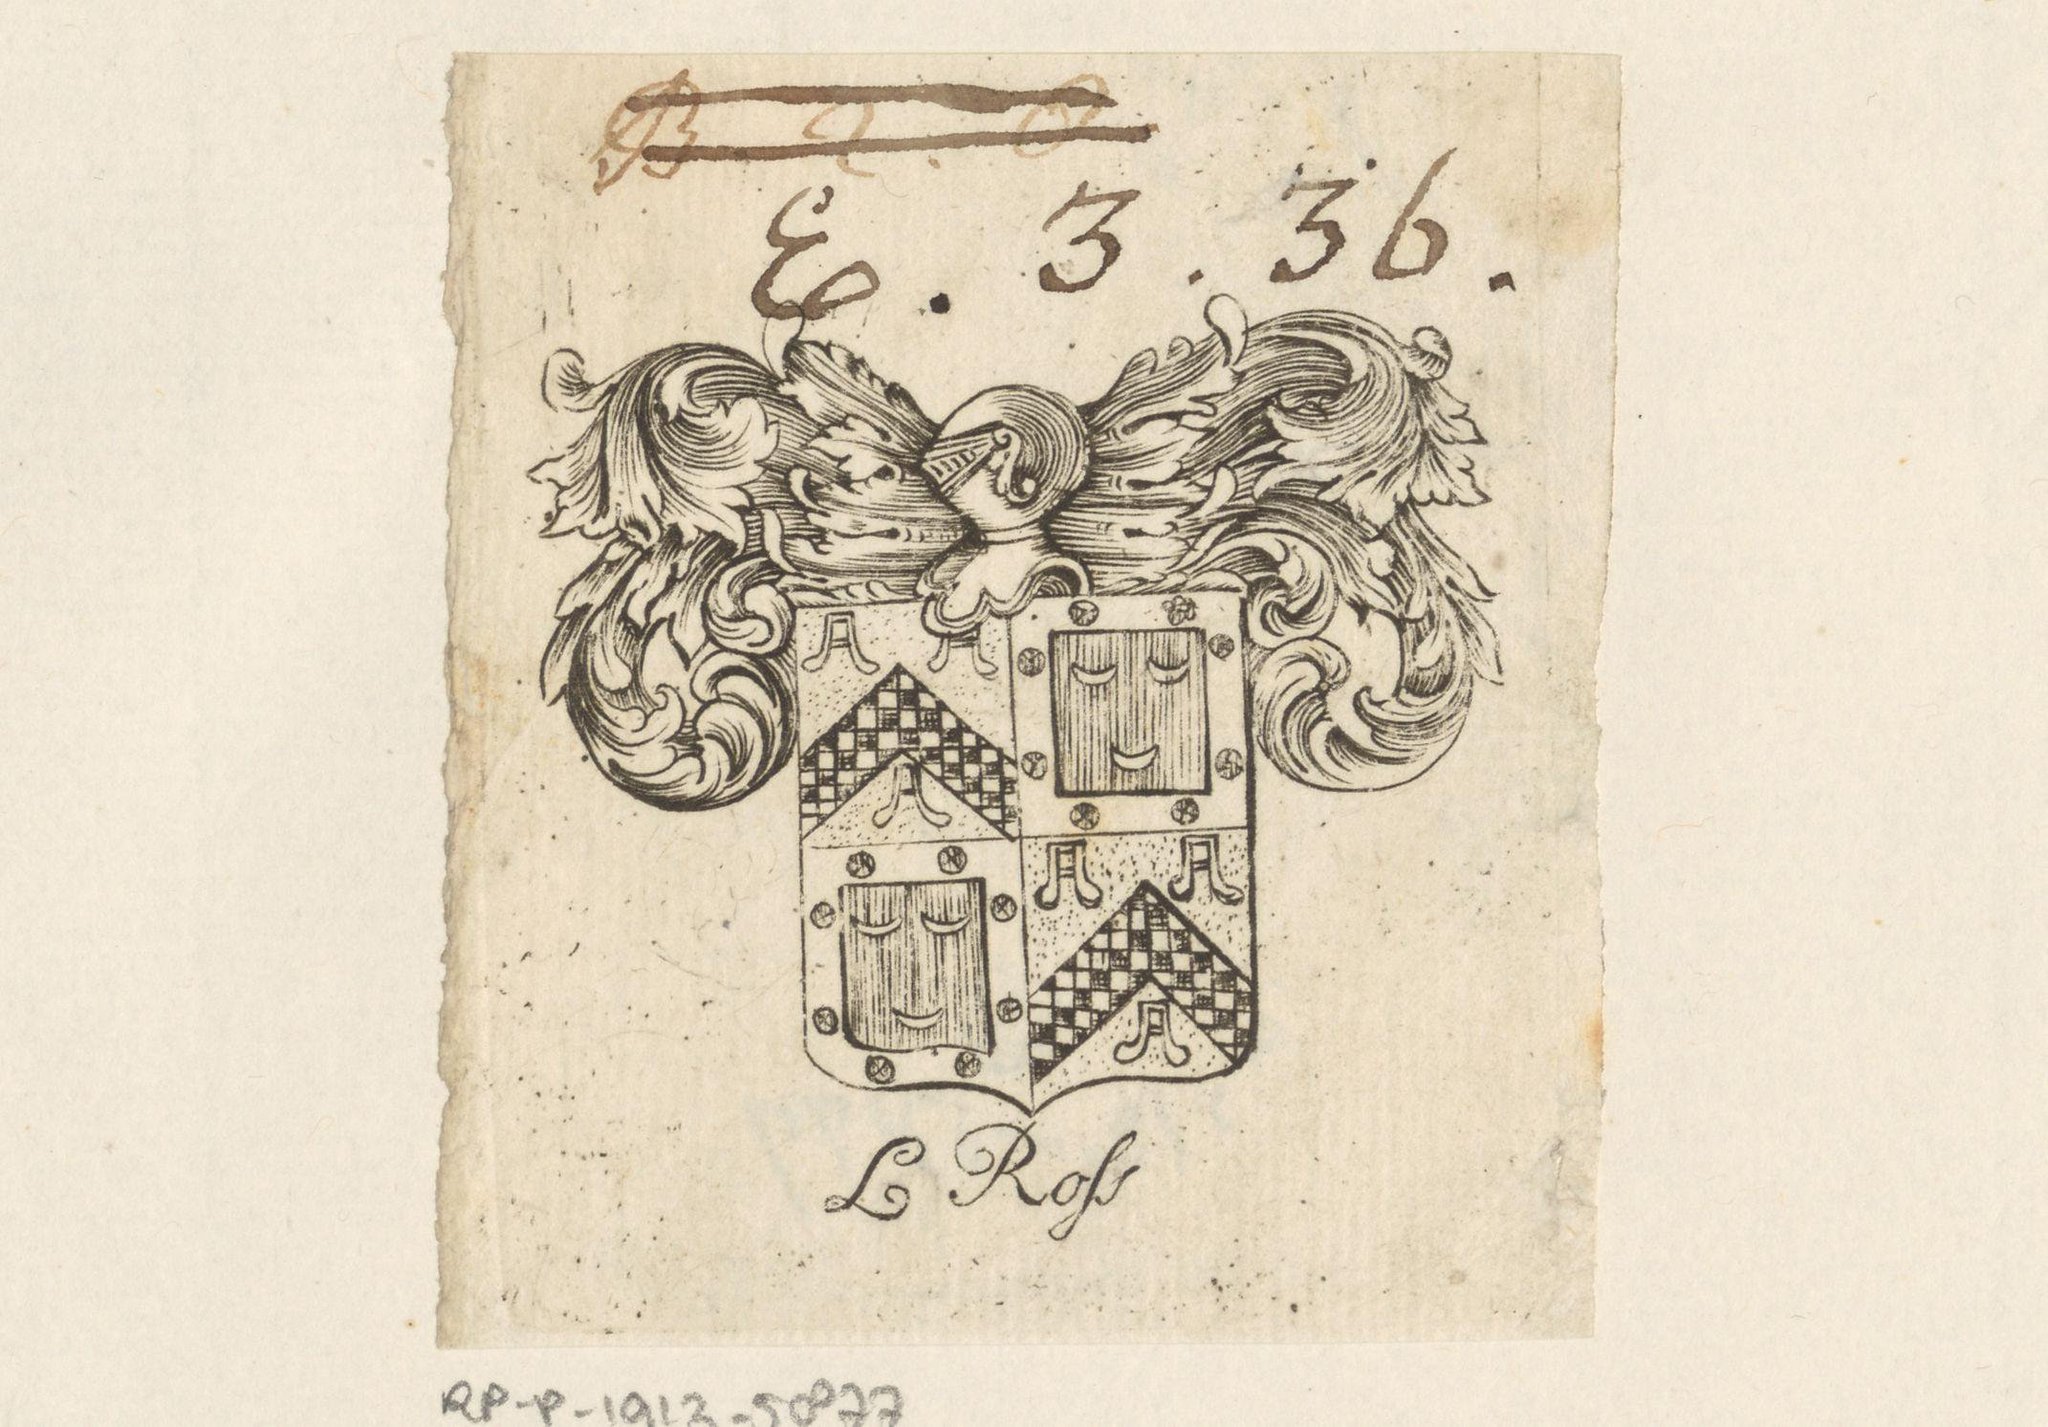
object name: bookplate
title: Ex libris van L. Ross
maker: Anonymous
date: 1650-1750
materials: paper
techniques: etching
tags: armorial bearing, heraldry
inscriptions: inscription: ‘E. 3. 36.’, collector's mark: Lugt 2233, collector's mark: Lugt 2760